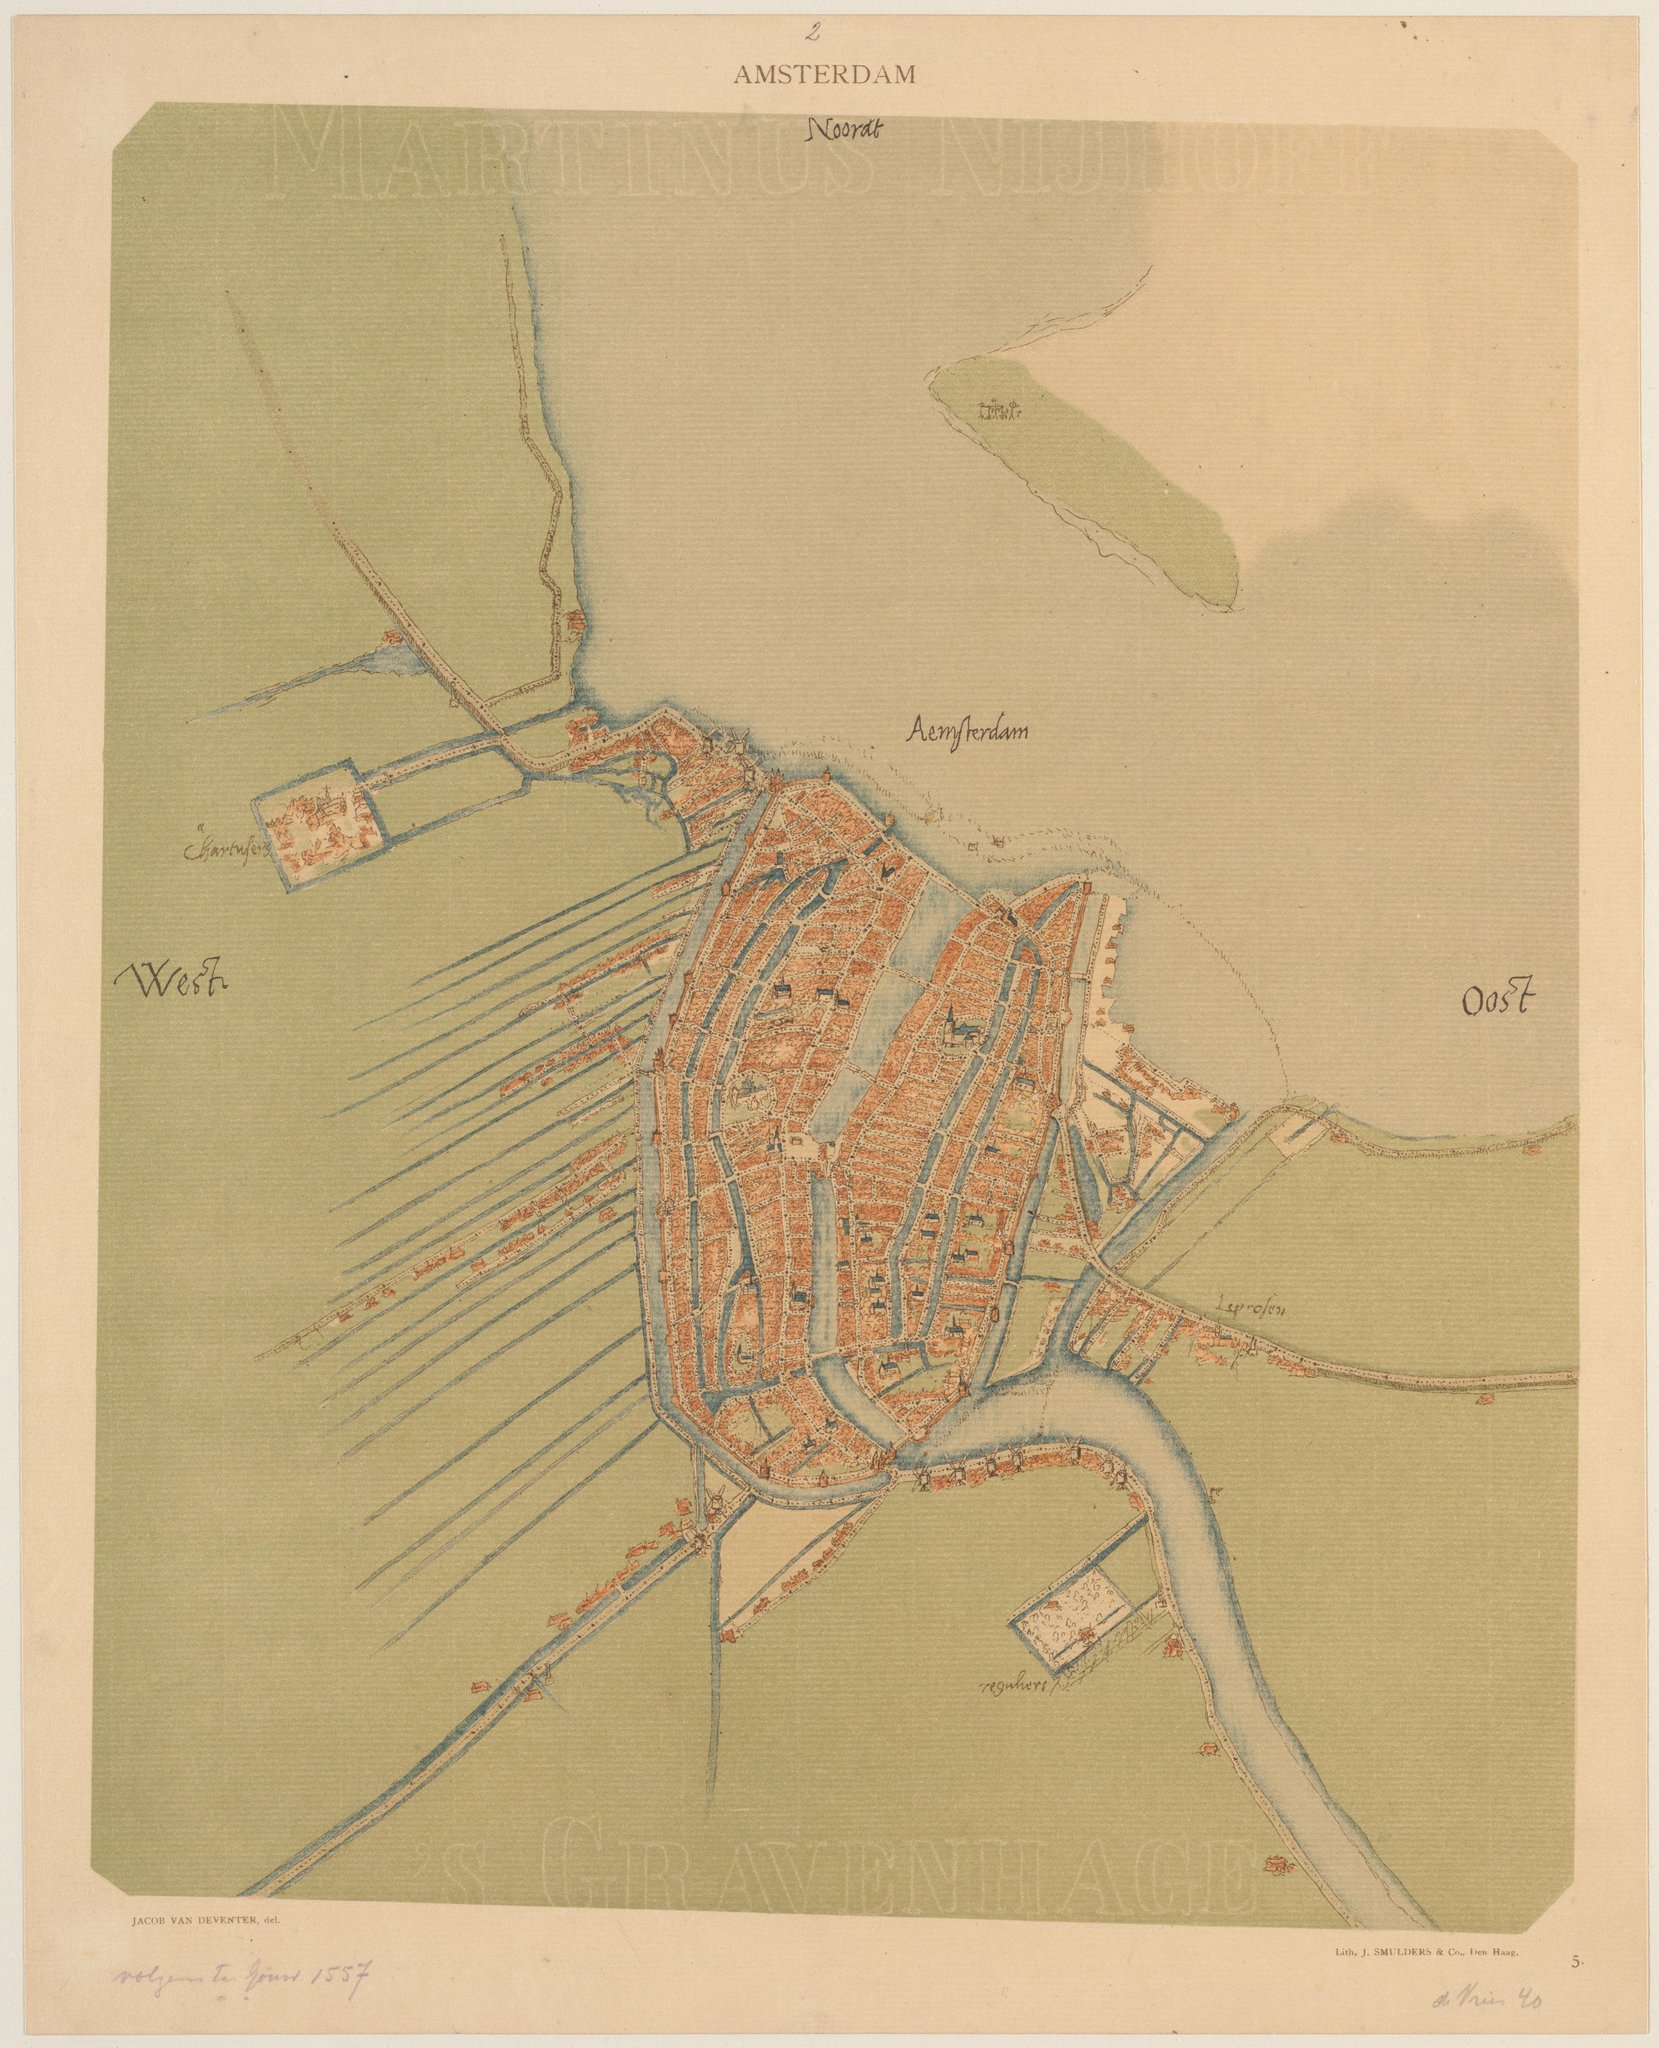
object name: print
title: Reproductie van de plattegrond van Amsterdam en omgeving door Jacob van Deventer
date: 1916-1923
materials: paper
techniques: lithograph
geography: the hague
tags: maps of cities, amsterdam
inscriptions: collector's mark: Lugt 1641b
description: Prent mogelijk uit: Fruin, Robert. Nederlandsche steden in de 16e eeuw Plattegronden van Jacob van Deventer. Den Haag: Martinus Nijhoff, 1916, pl. 5. Of uit latere editie van 1916-1923.